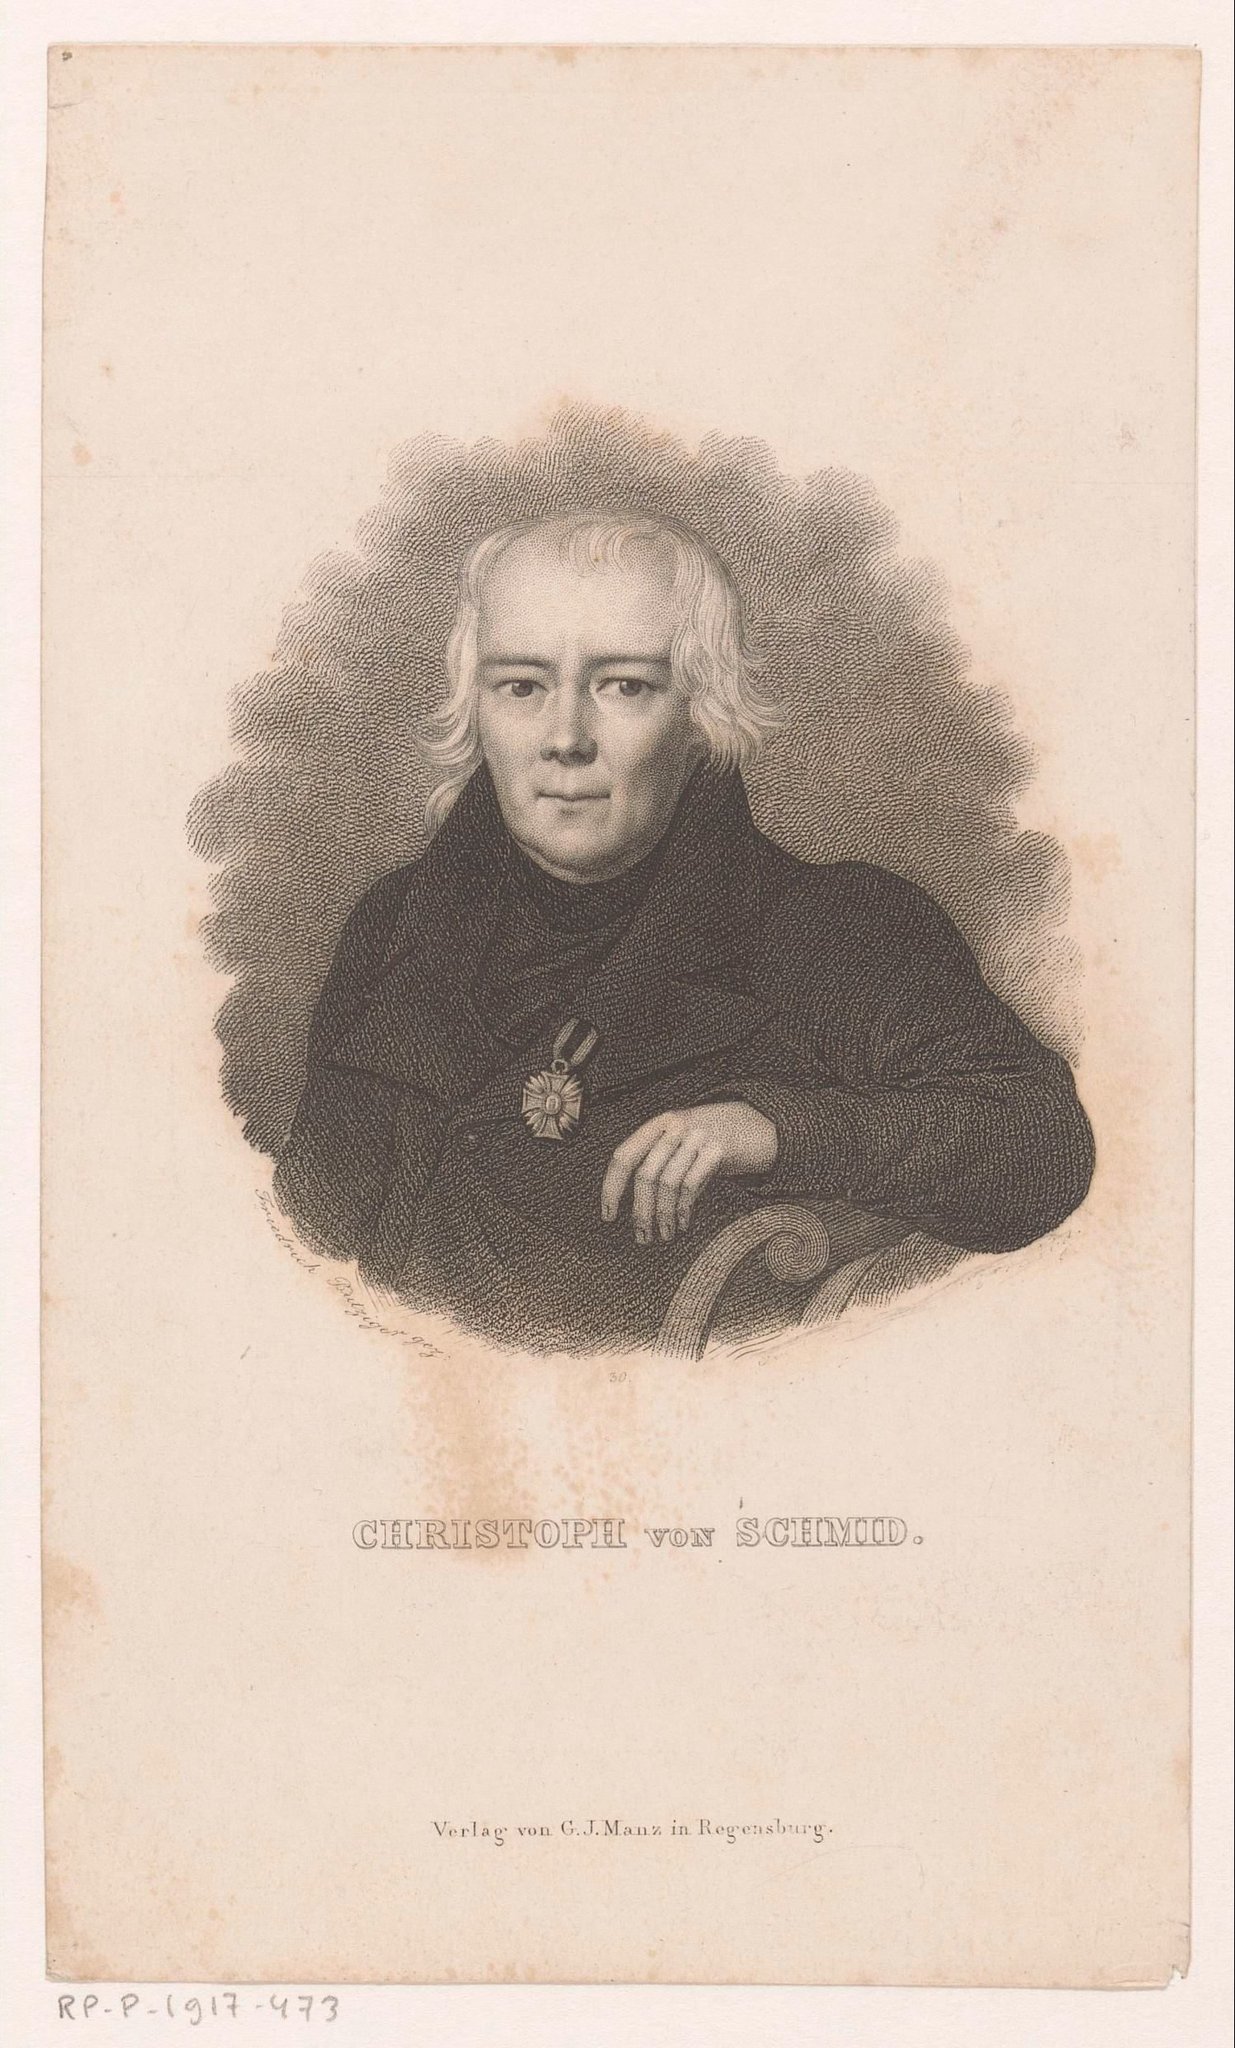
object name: print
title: Portret van Christoph von Schmid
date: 1835-1868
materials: paper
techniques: engraving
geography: nuremberg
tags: augsburg, clergyman, knighthood order, historical persons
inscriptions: collector's mark: Lugt 2228